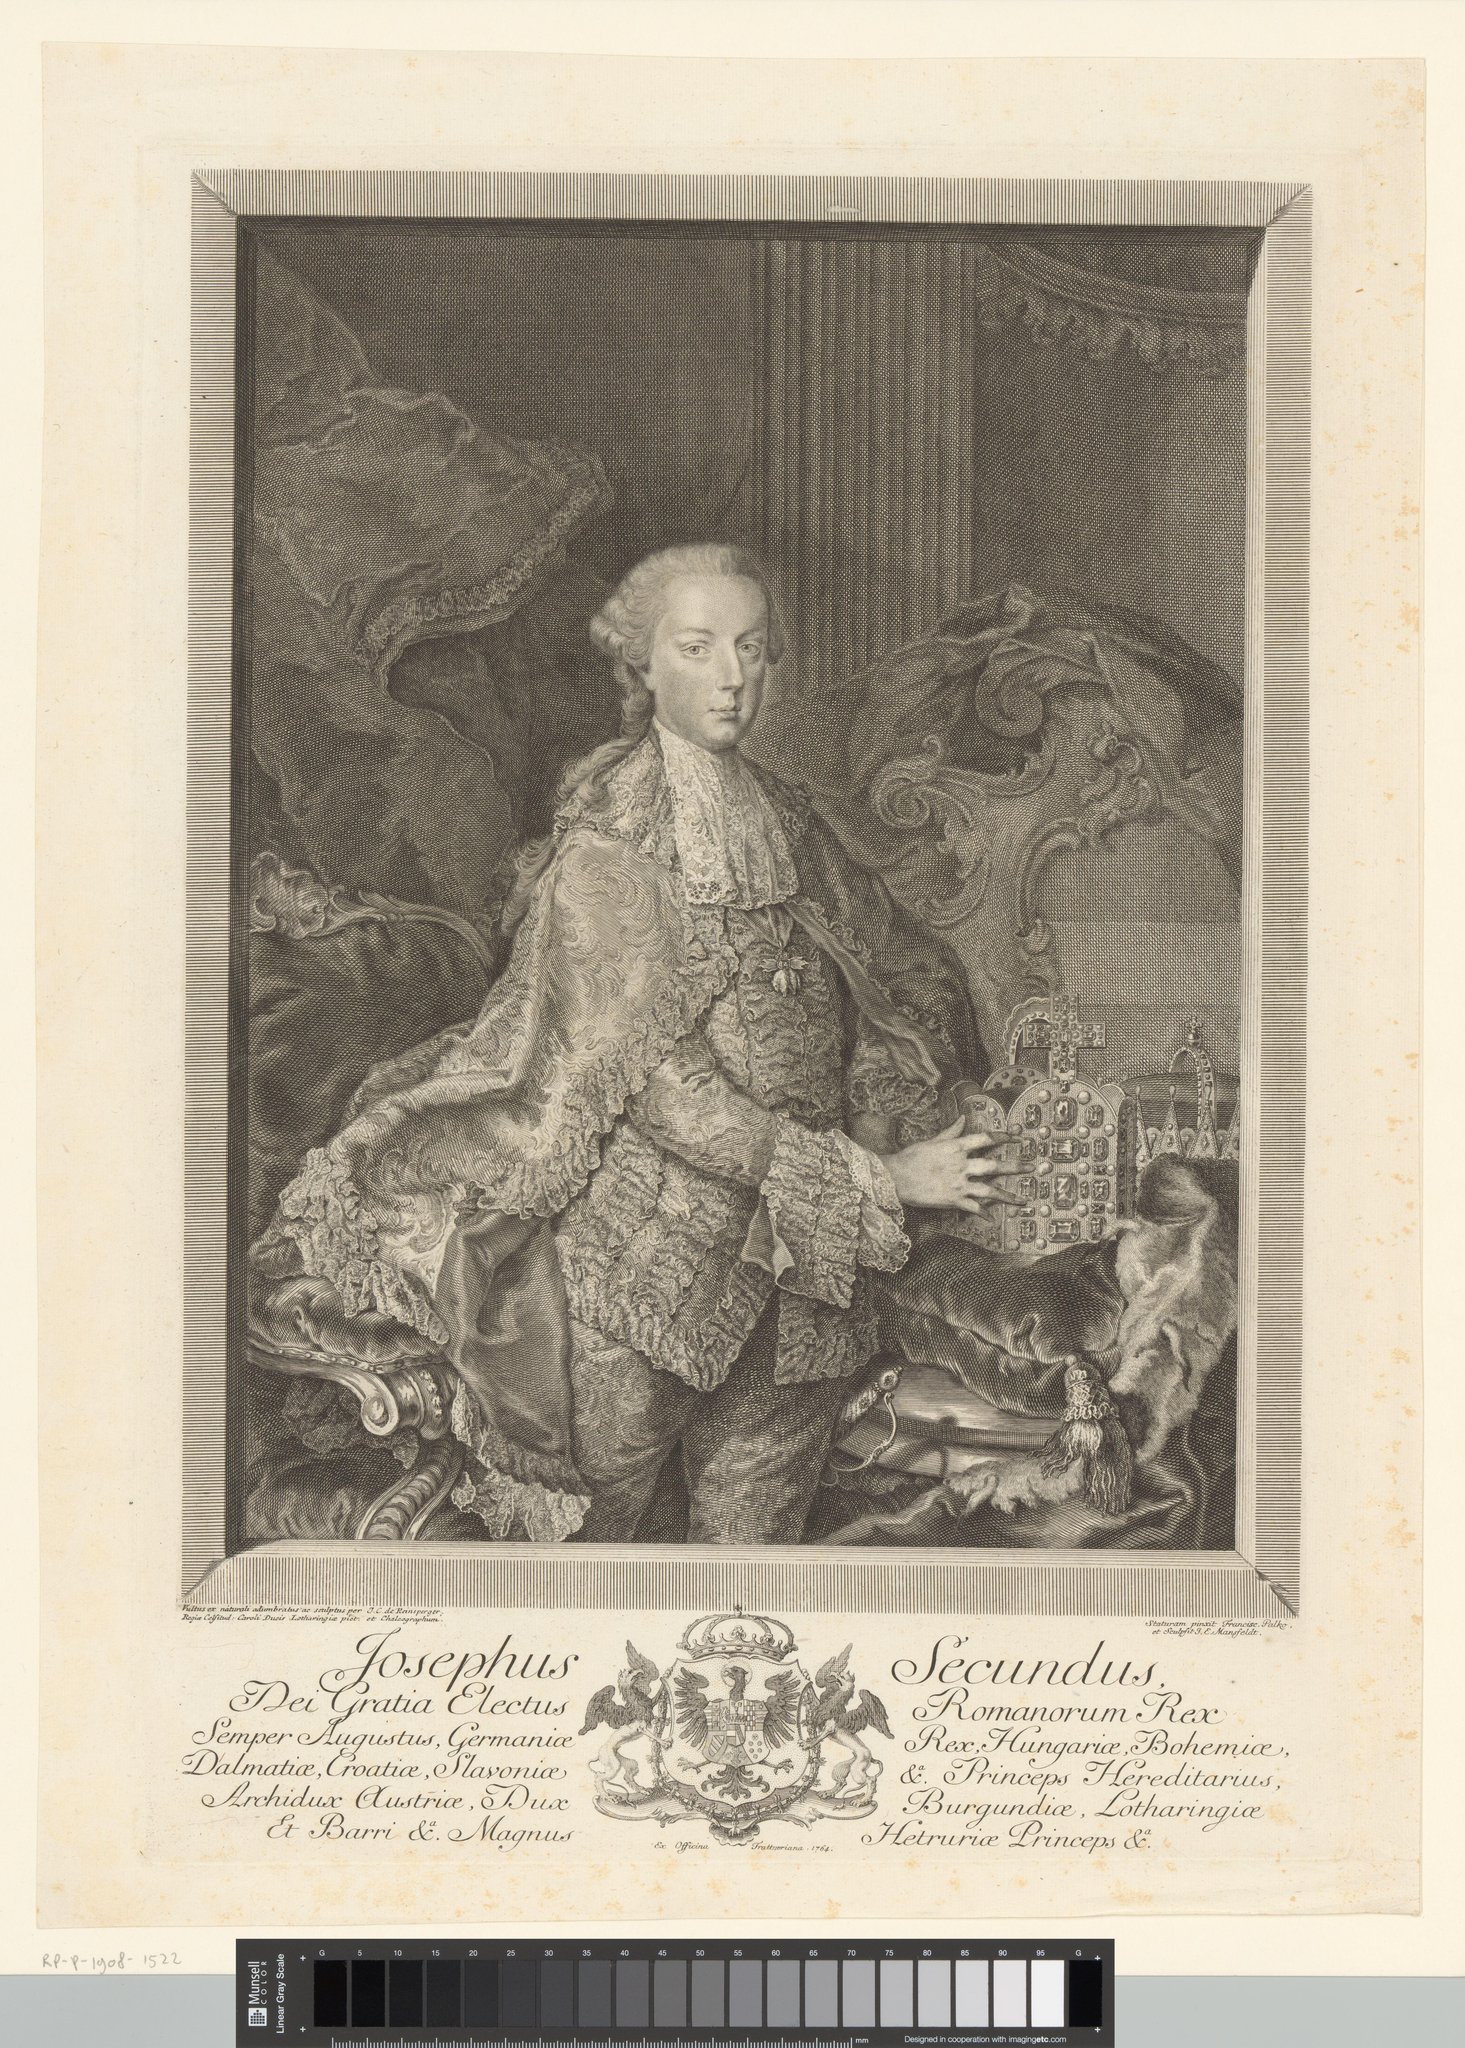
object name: print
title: Portret van Jozef II, Duits keizer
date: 1764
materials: paper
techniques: engraving, etching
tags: jozef ii (duits keizer), historical persons, armorial bearing, heraldry, insignia and symbols of sovereignty (crown, diadem, sceptre, orb, seal, standard, cloak, pectoral)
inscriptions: collector's mark: Lugt 2228